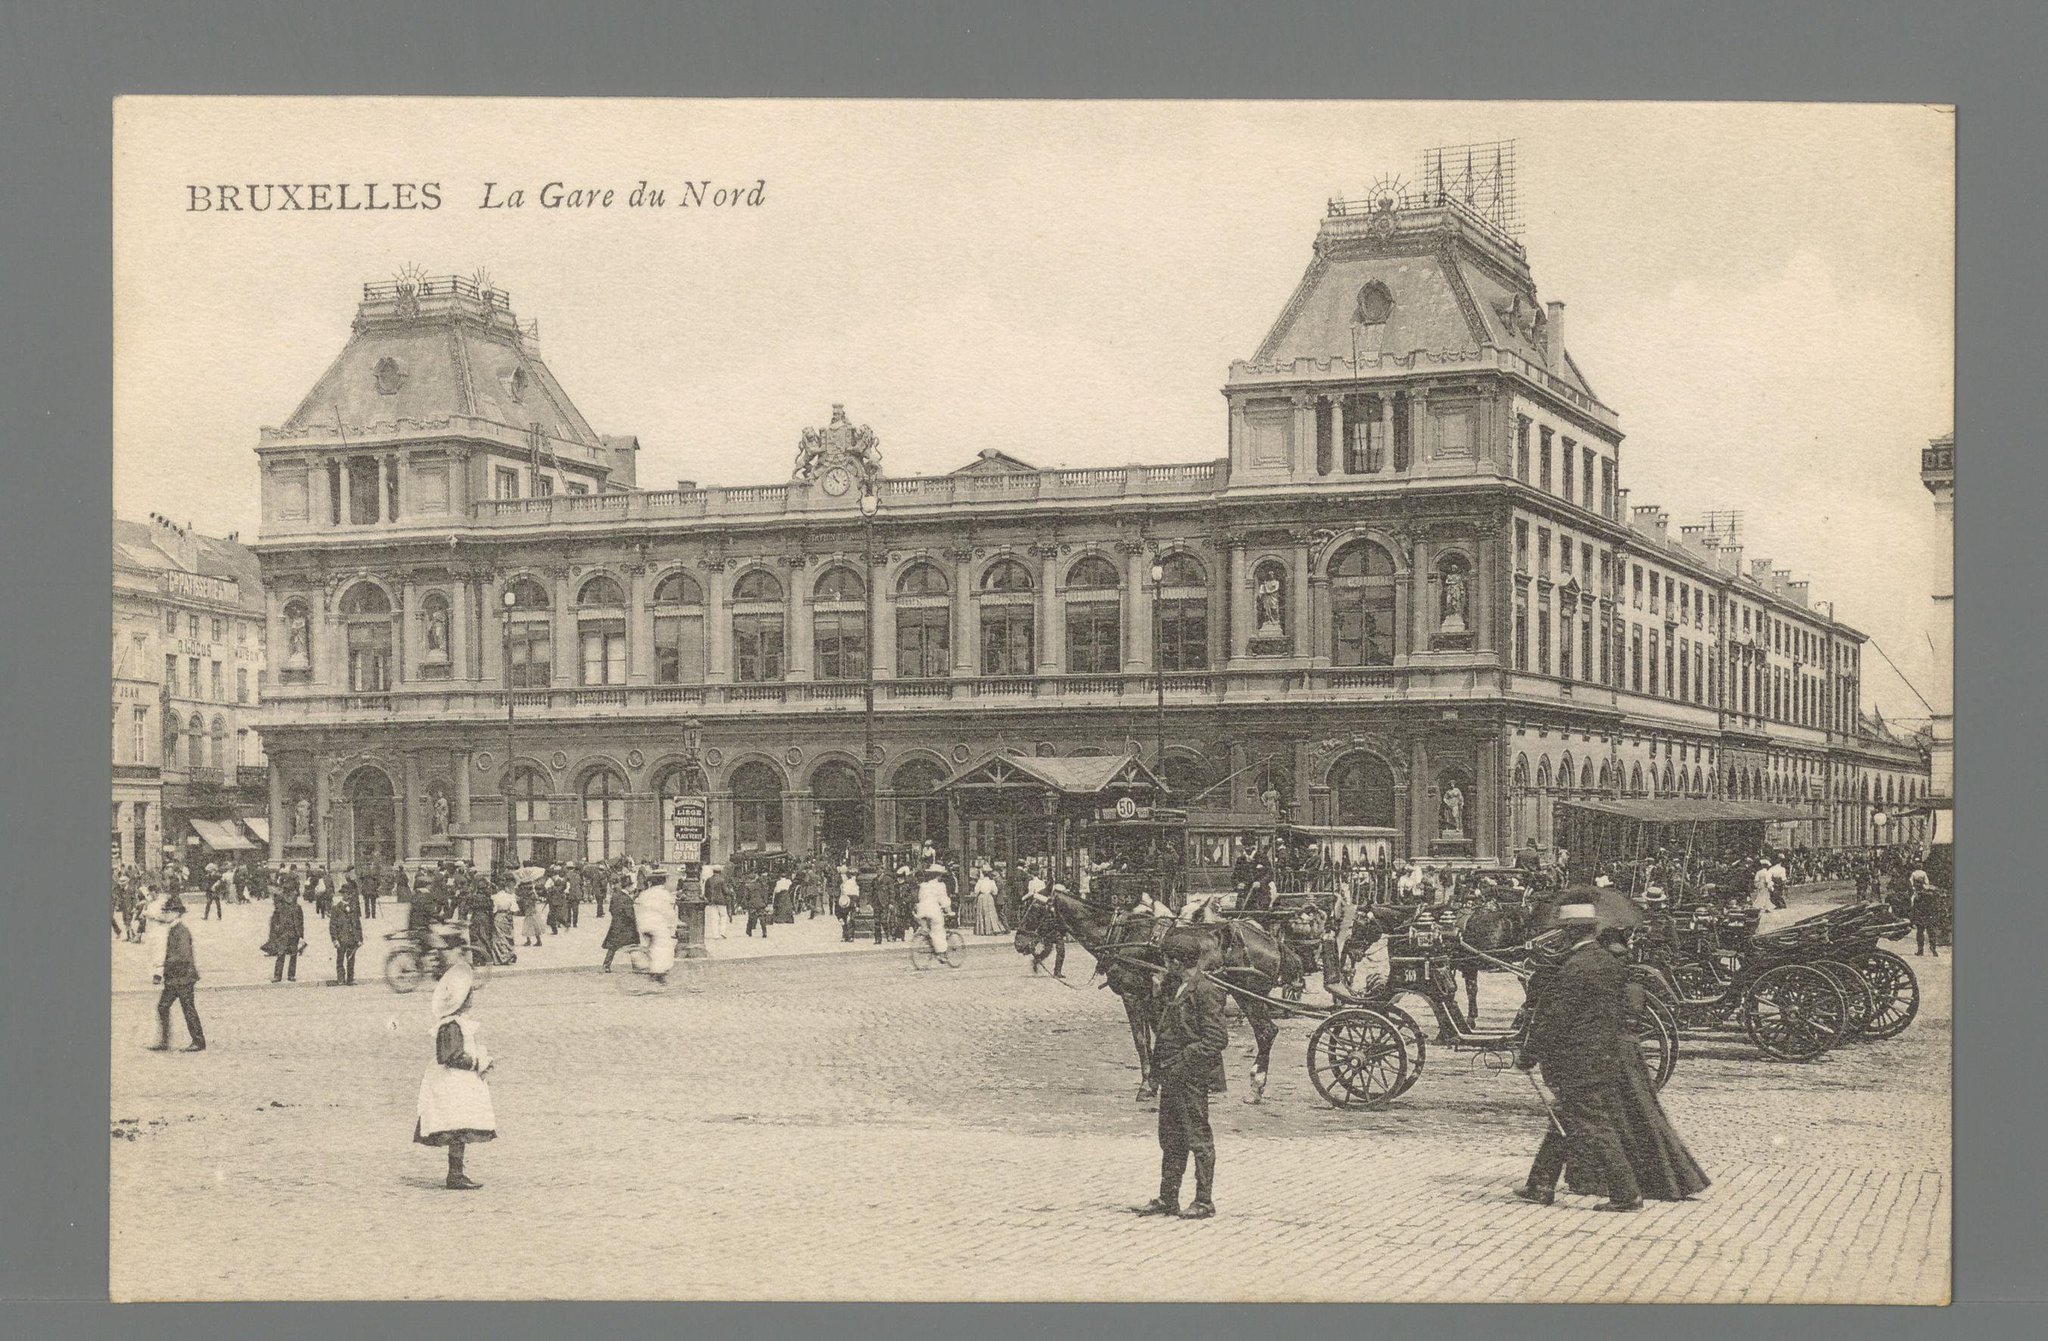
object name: photomechanical print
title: Bruxelles. La Gare du Nord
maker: Anonymous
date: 1906-1930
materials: cardboard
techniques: photograph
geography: brussels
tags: station; shelter (railway, tramway), city-view, and landscape with man-made constructions (+ city(-scape) with figures, staffage), brussels